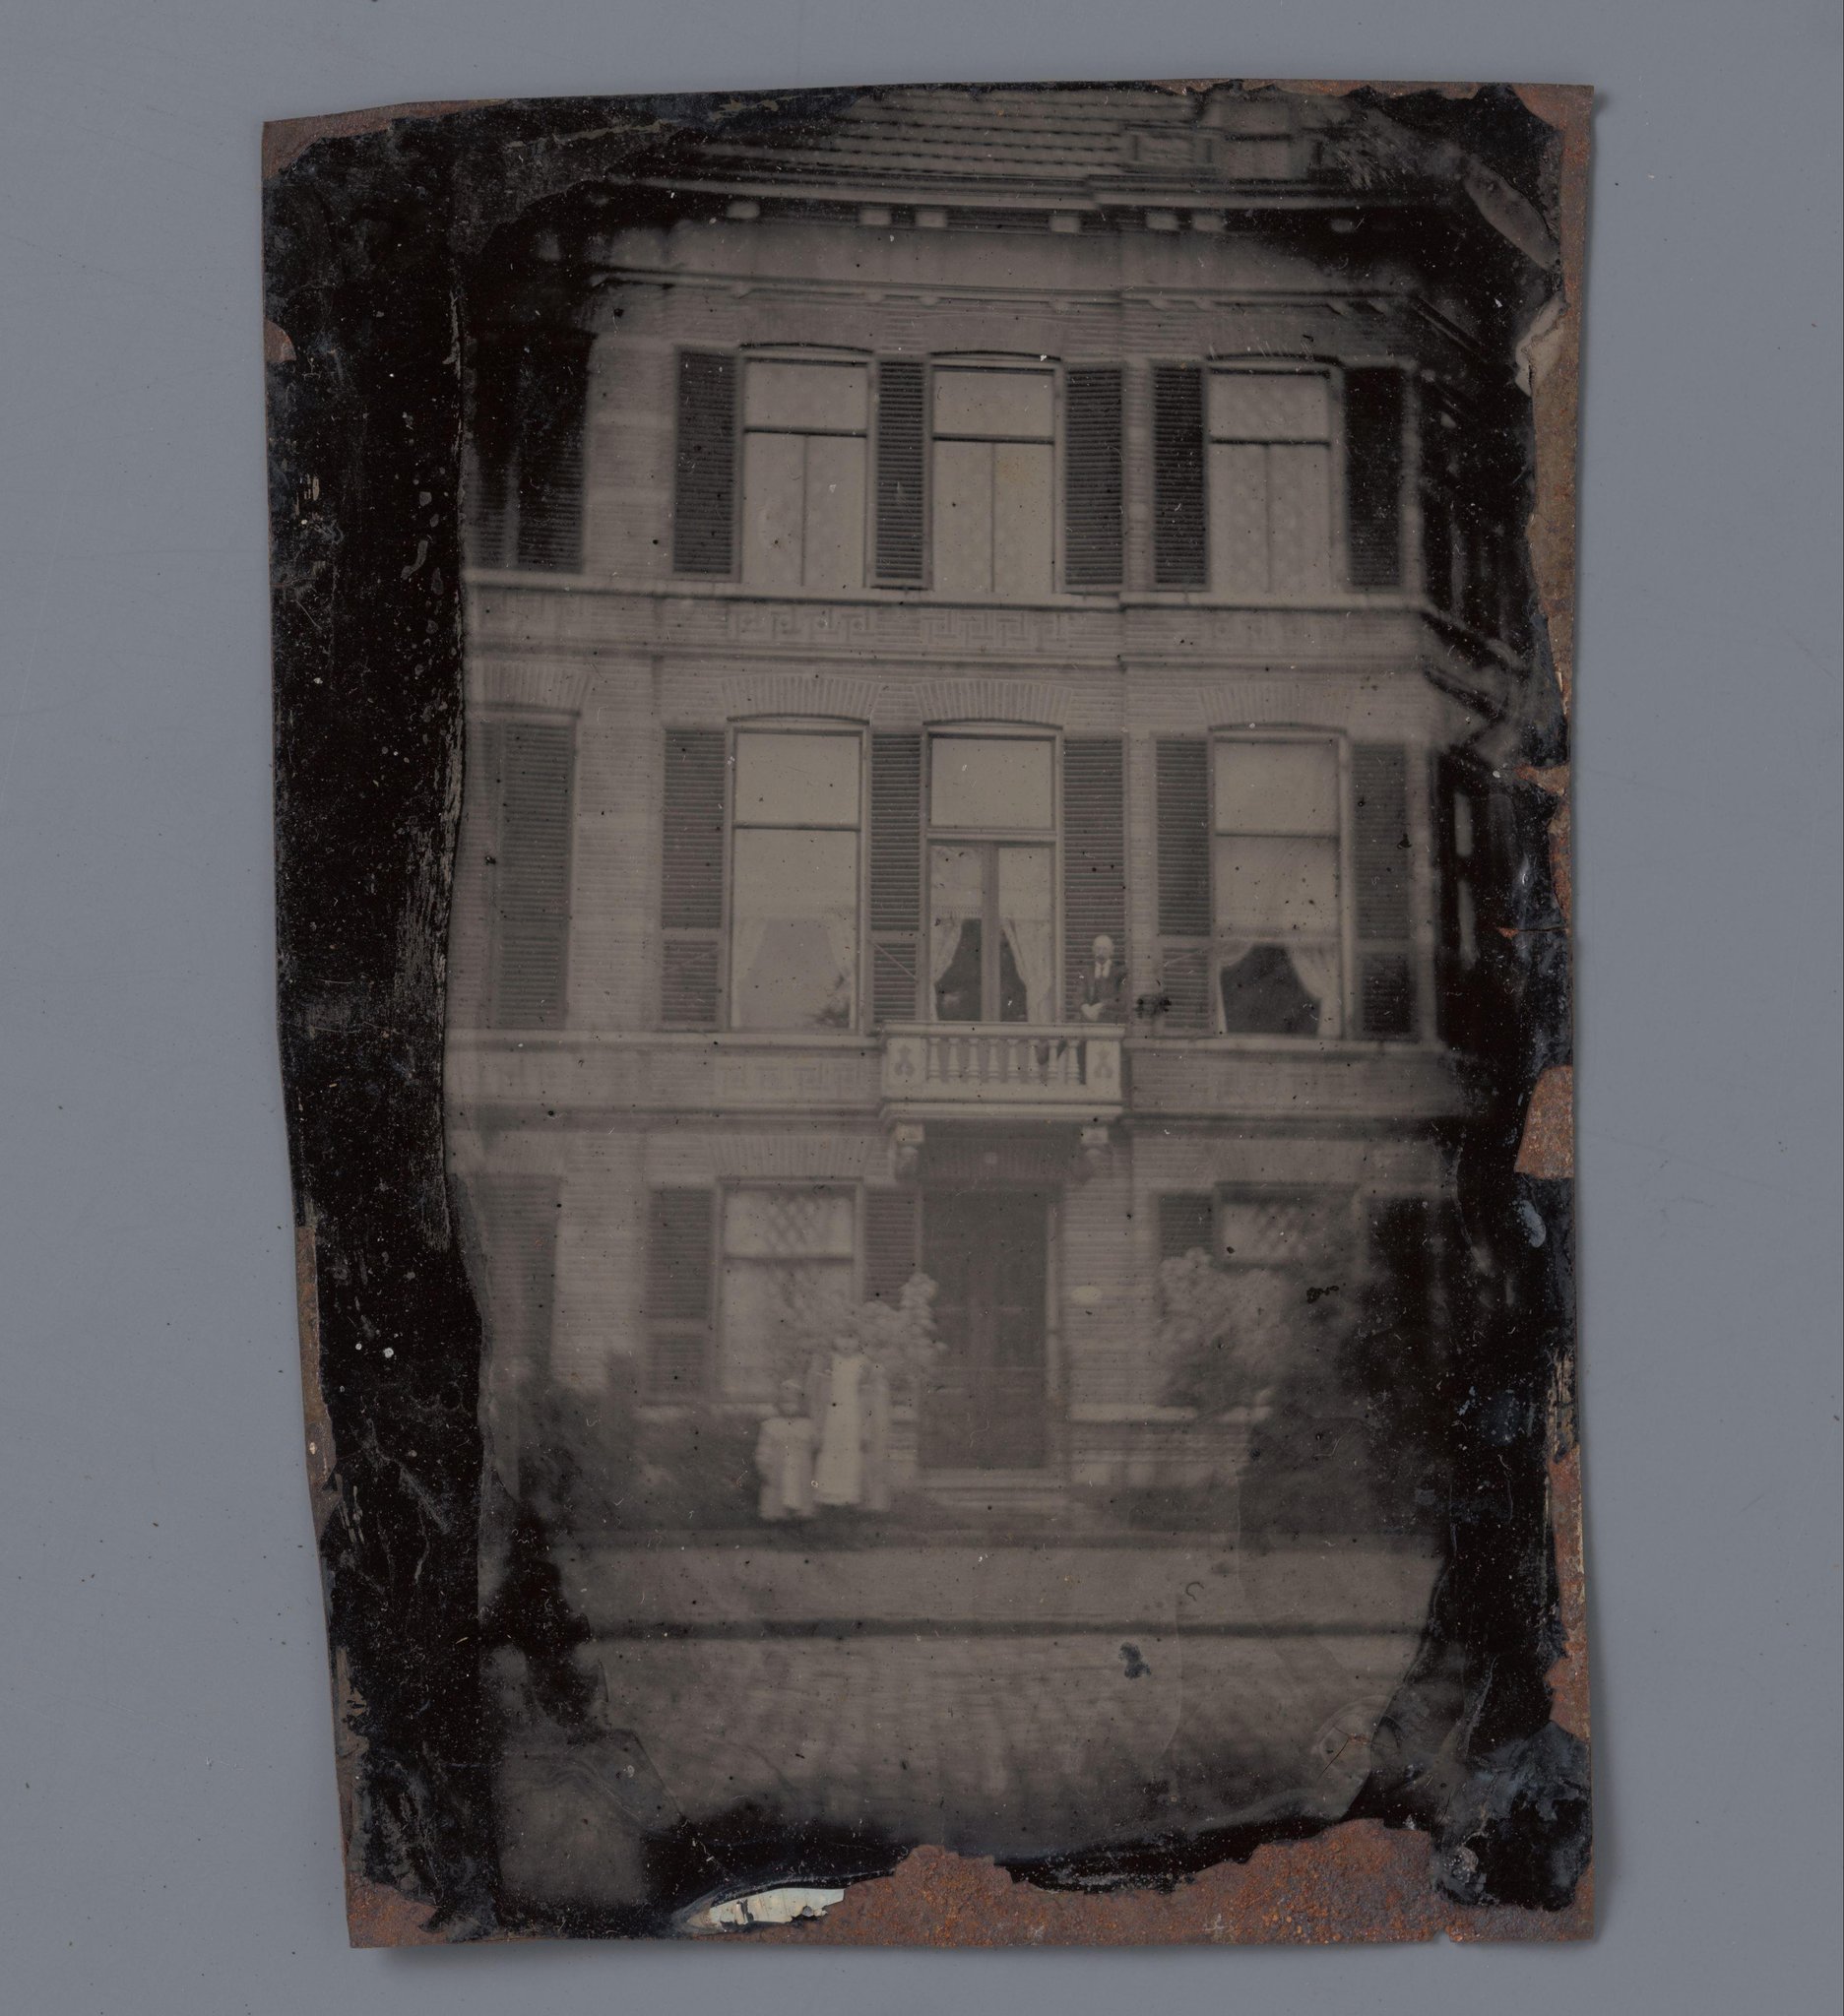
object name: photograph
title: Gezicht op een huis met enkele personen ervoor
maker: Anonymous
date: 1855-1940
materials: iron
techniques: ferrotyping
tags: adult man, front façade